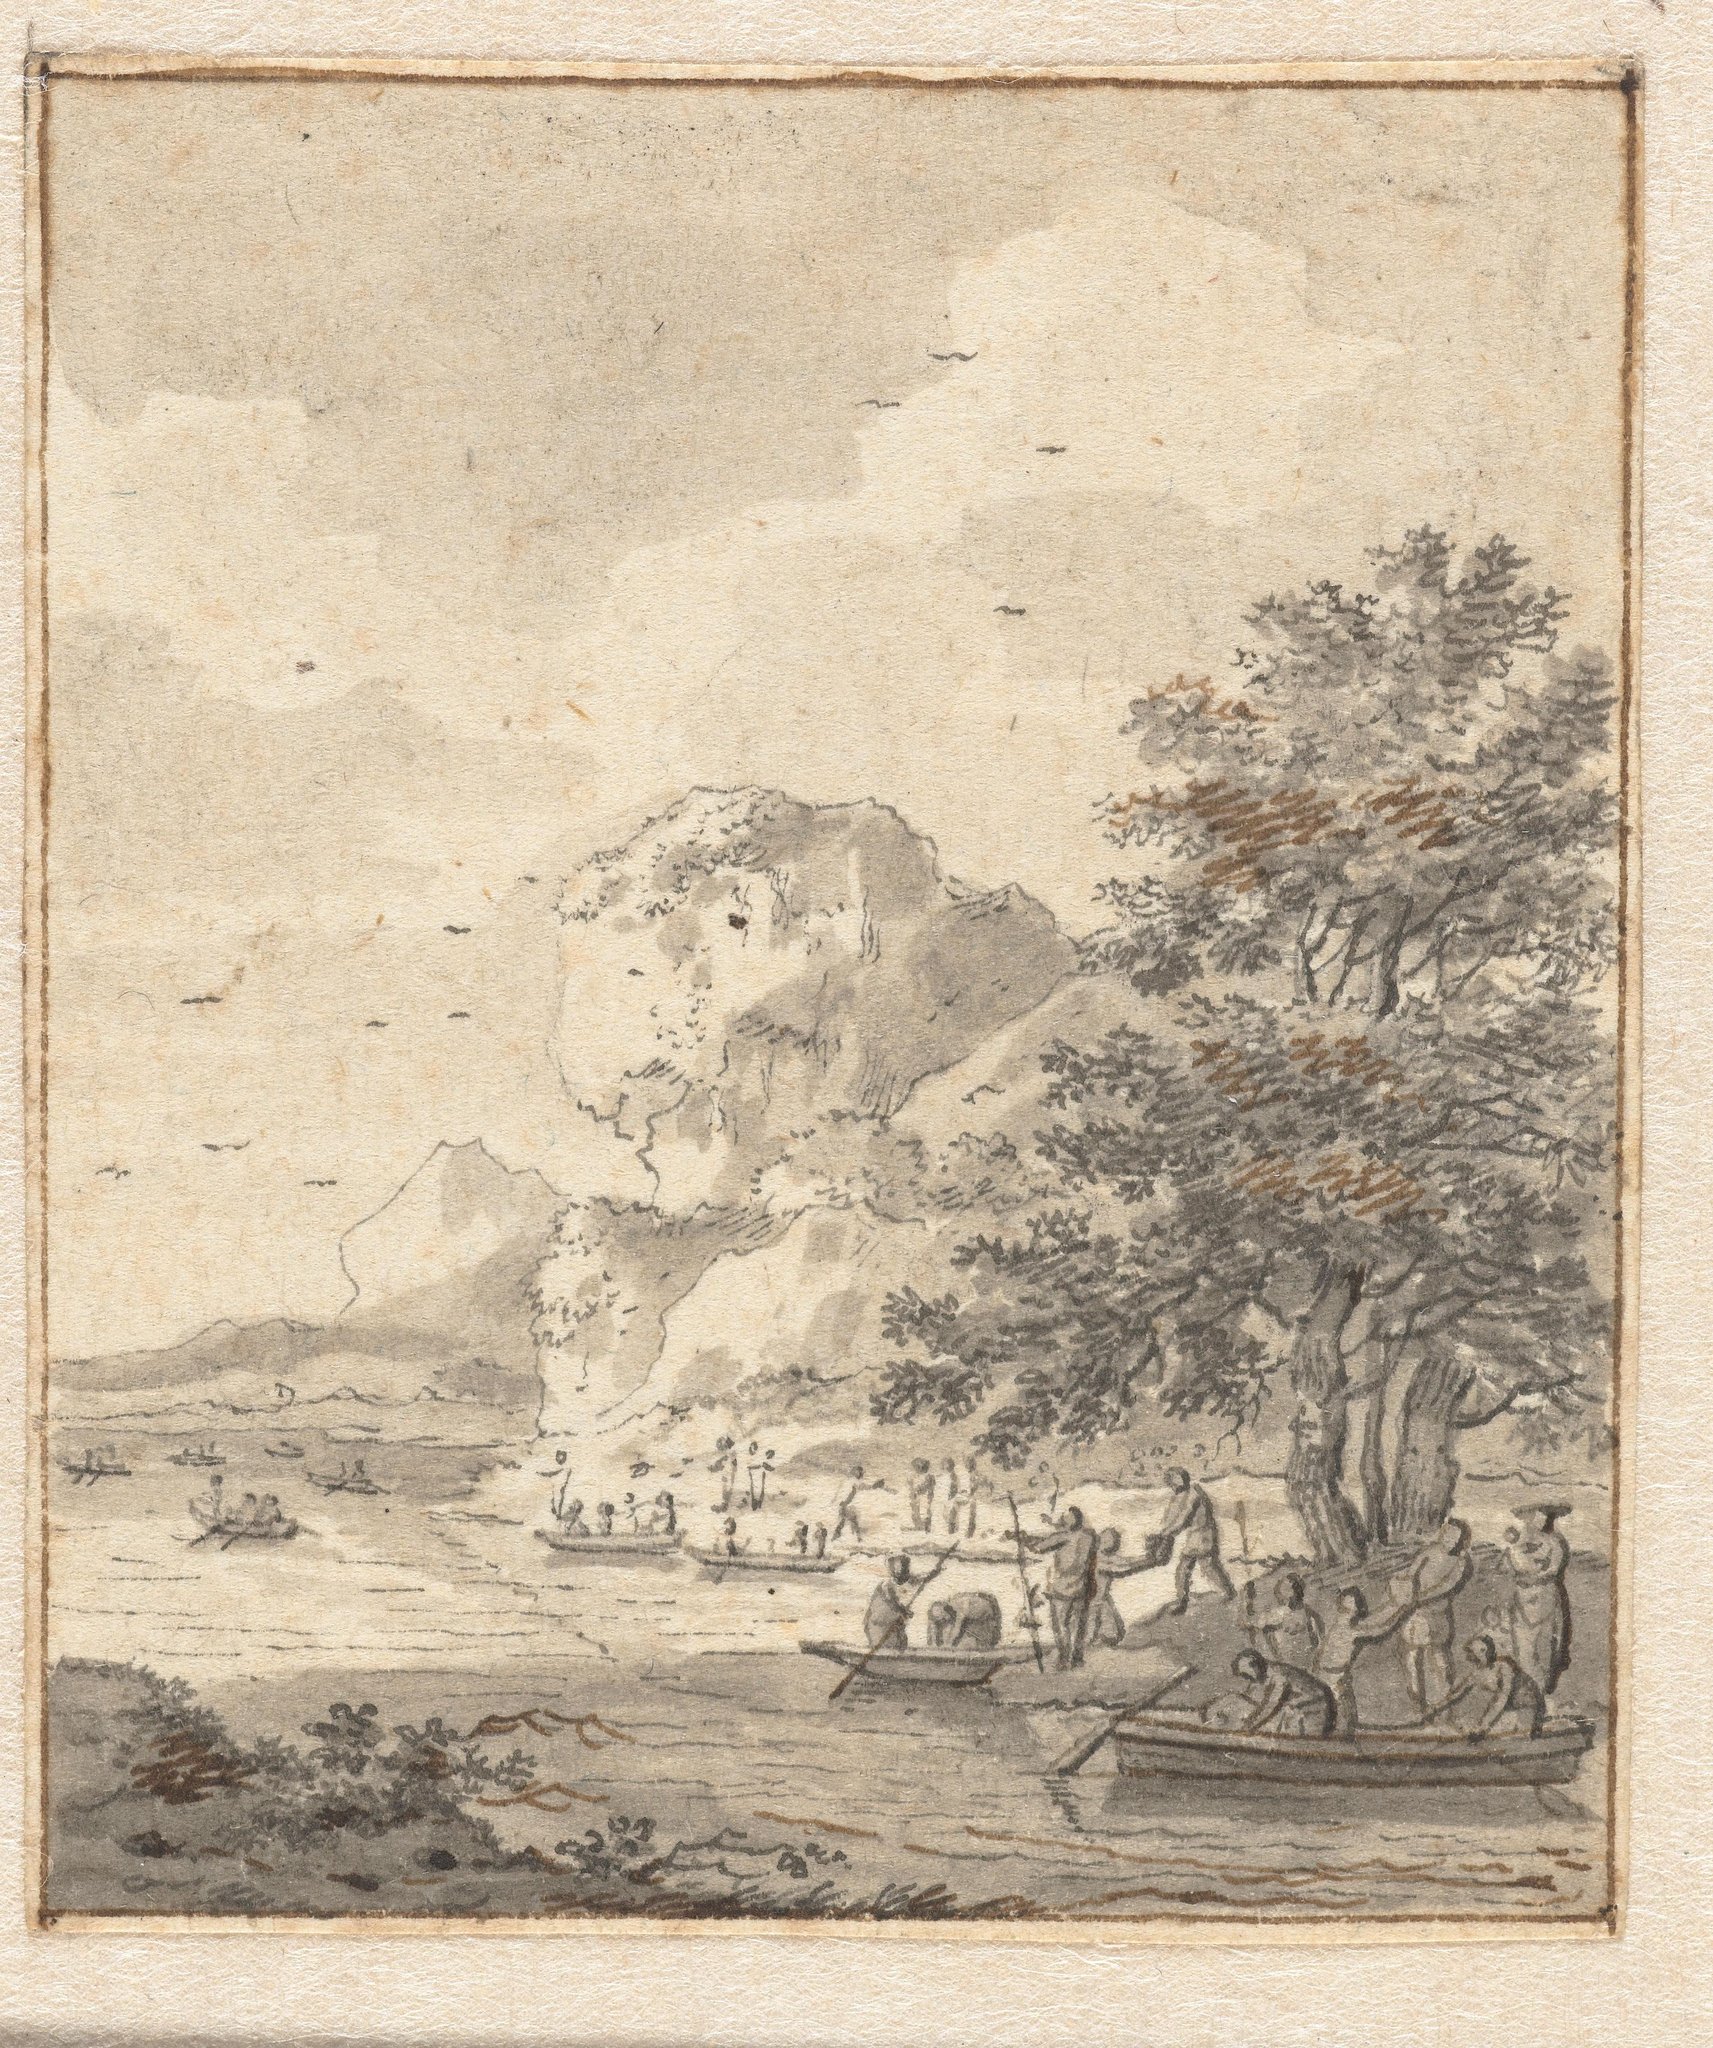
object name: drawing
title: Omtrent 100 Jaar voor Christus geboorte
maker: Anonymous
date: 1789-1810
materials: ink, paper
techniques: brush, pen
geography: netherlands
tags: extinct, 'historical' peoples (with name)